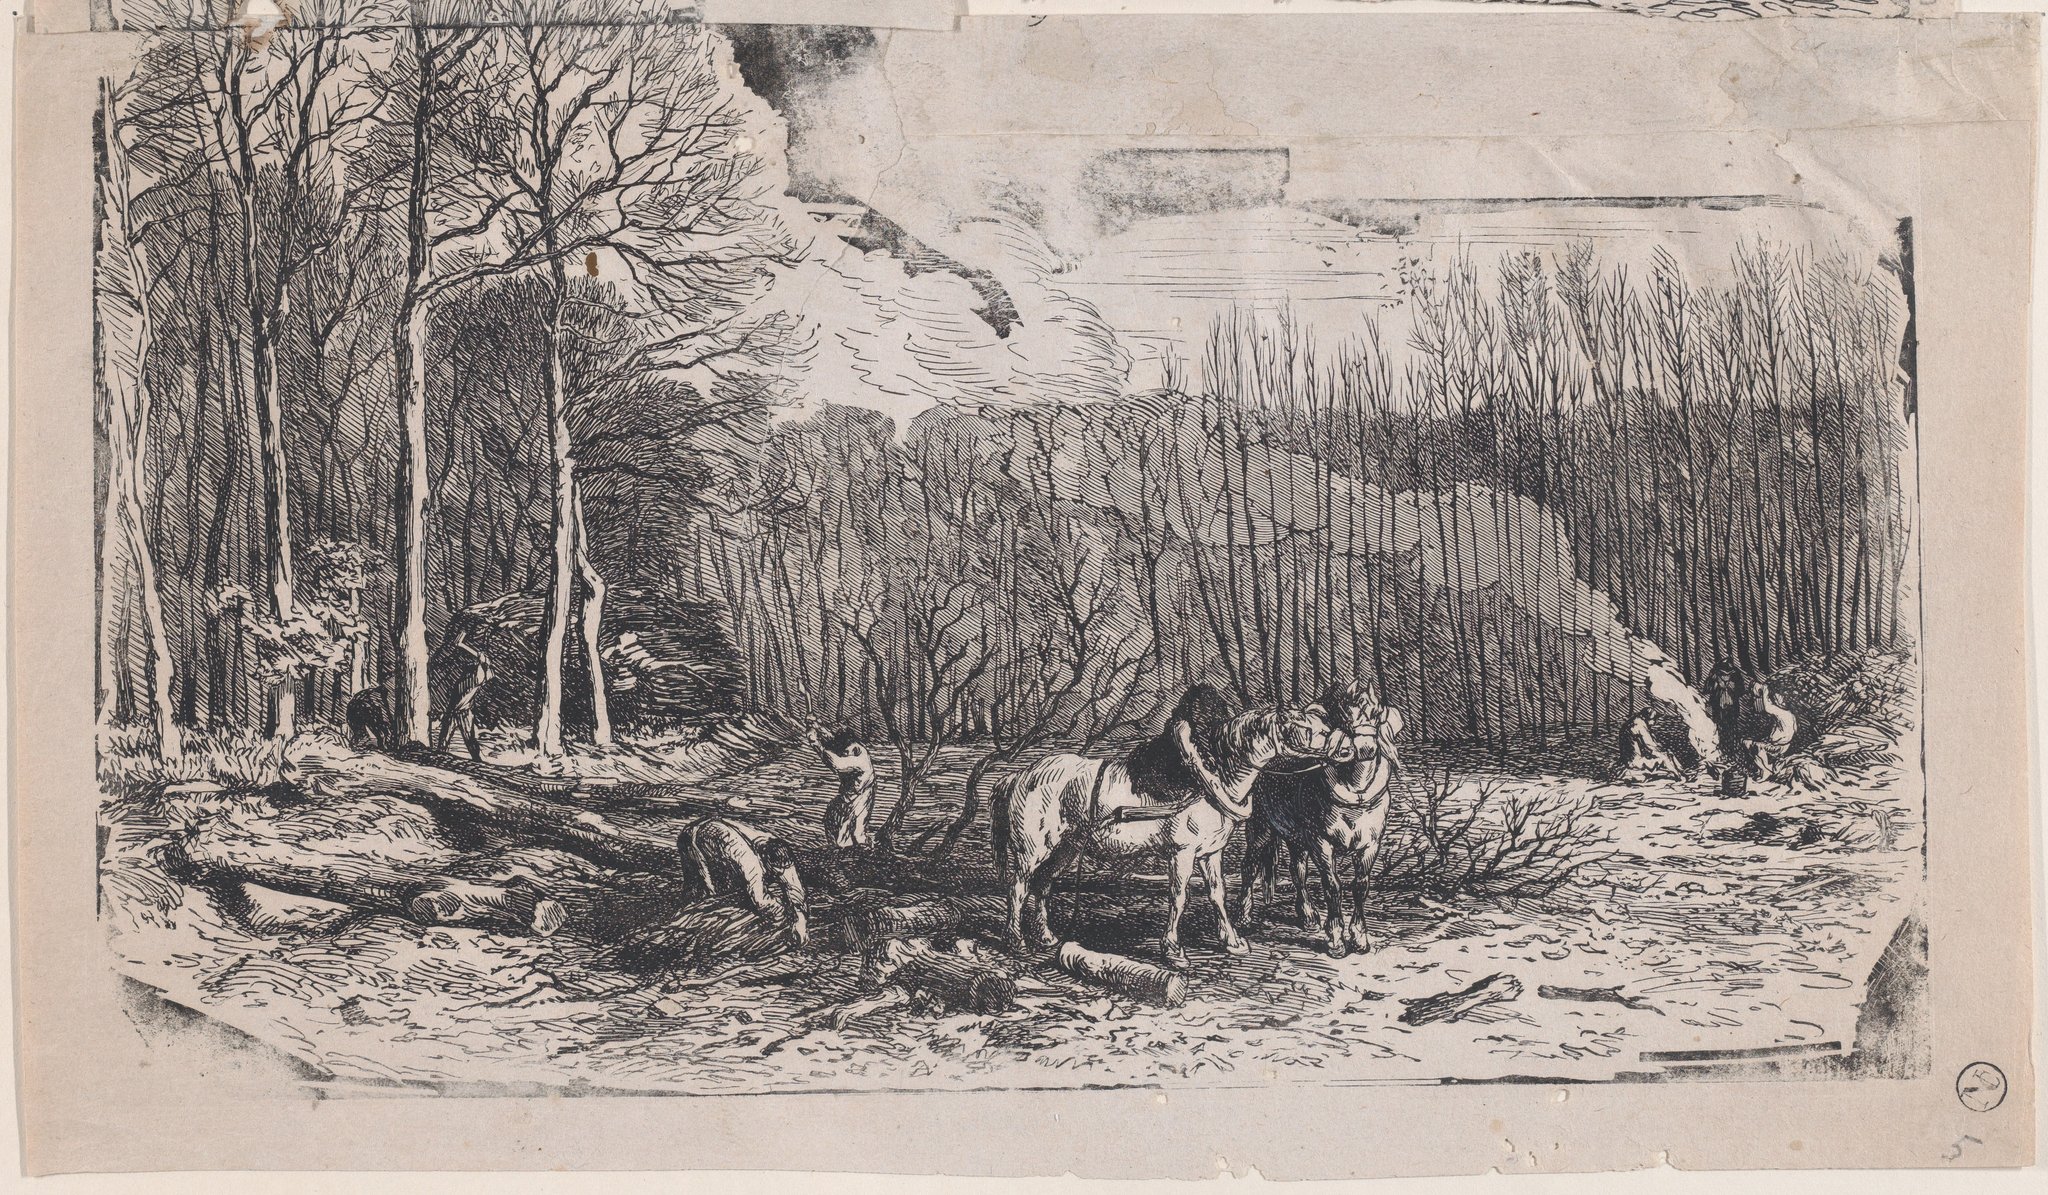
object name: print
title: February, from "Album of Rustic Subjects"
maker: charles émile jacque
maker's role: artist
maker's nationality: french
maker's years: 1813-1894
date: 1859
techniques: engraving